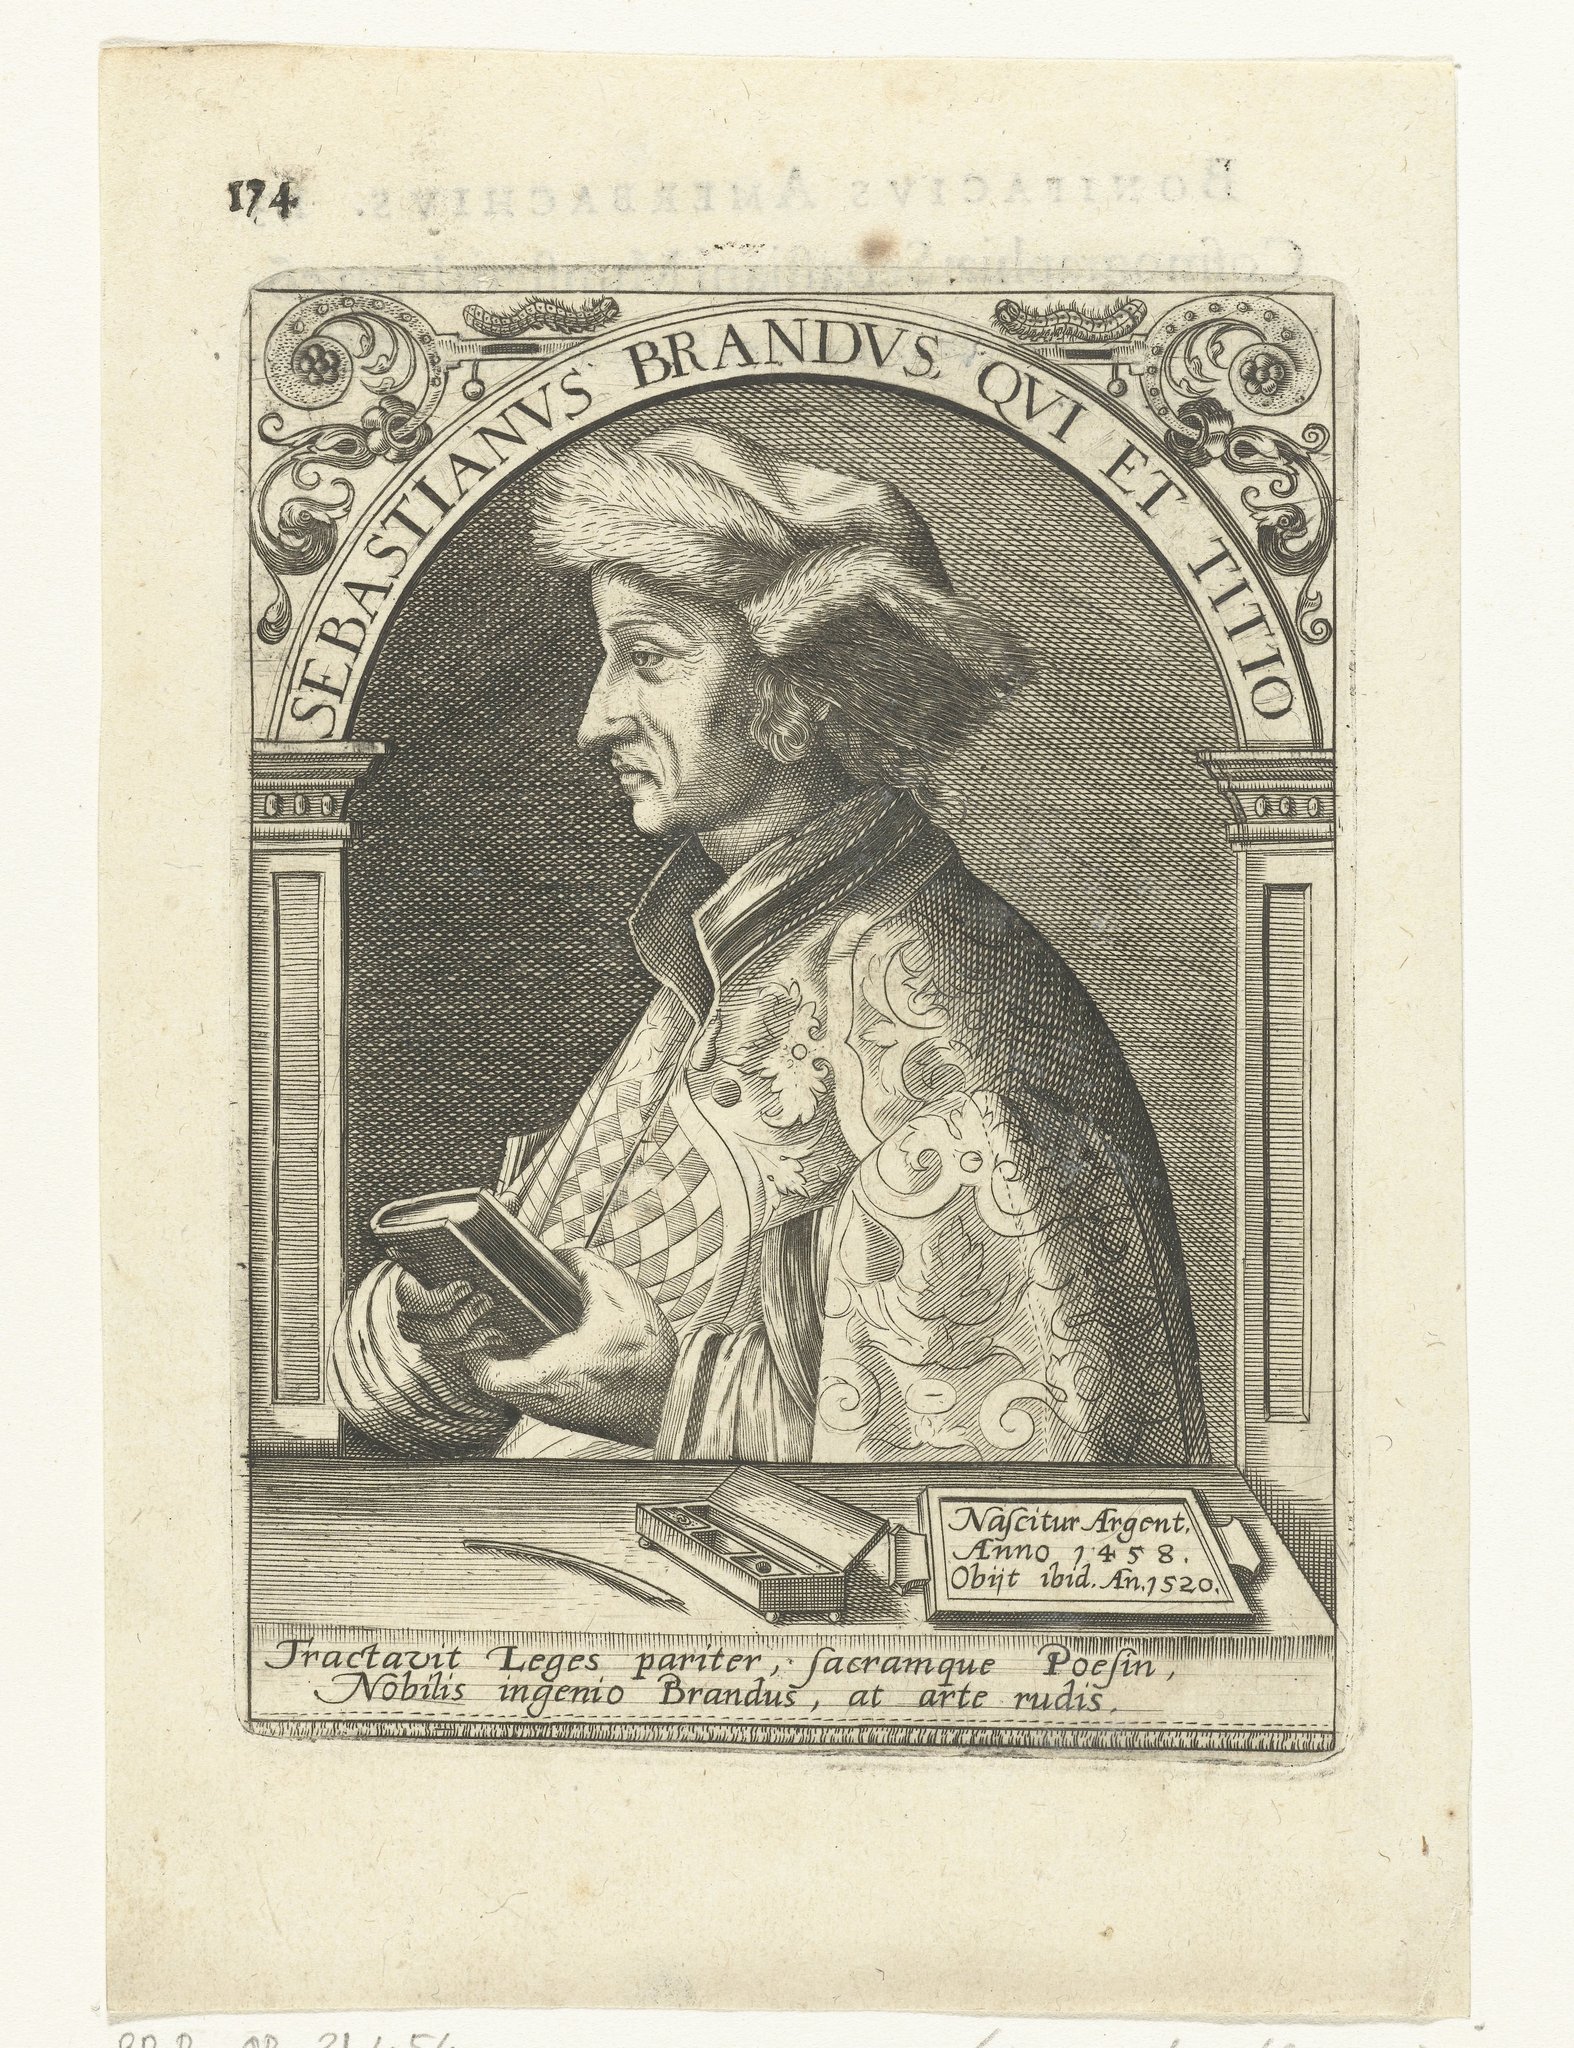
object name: book illustration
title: Sebastianvs Brandvs qvi et Titio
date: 1597-1599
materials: paper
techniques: engraving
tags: sebastian brant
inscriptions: collector's mark: Lugt 2228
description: Portret van de humanist Sebastian Brant met bontmuts en een boek in zijn handen. Op tafel ligt een schrijfveer. Onder het portret een Latijns vers.